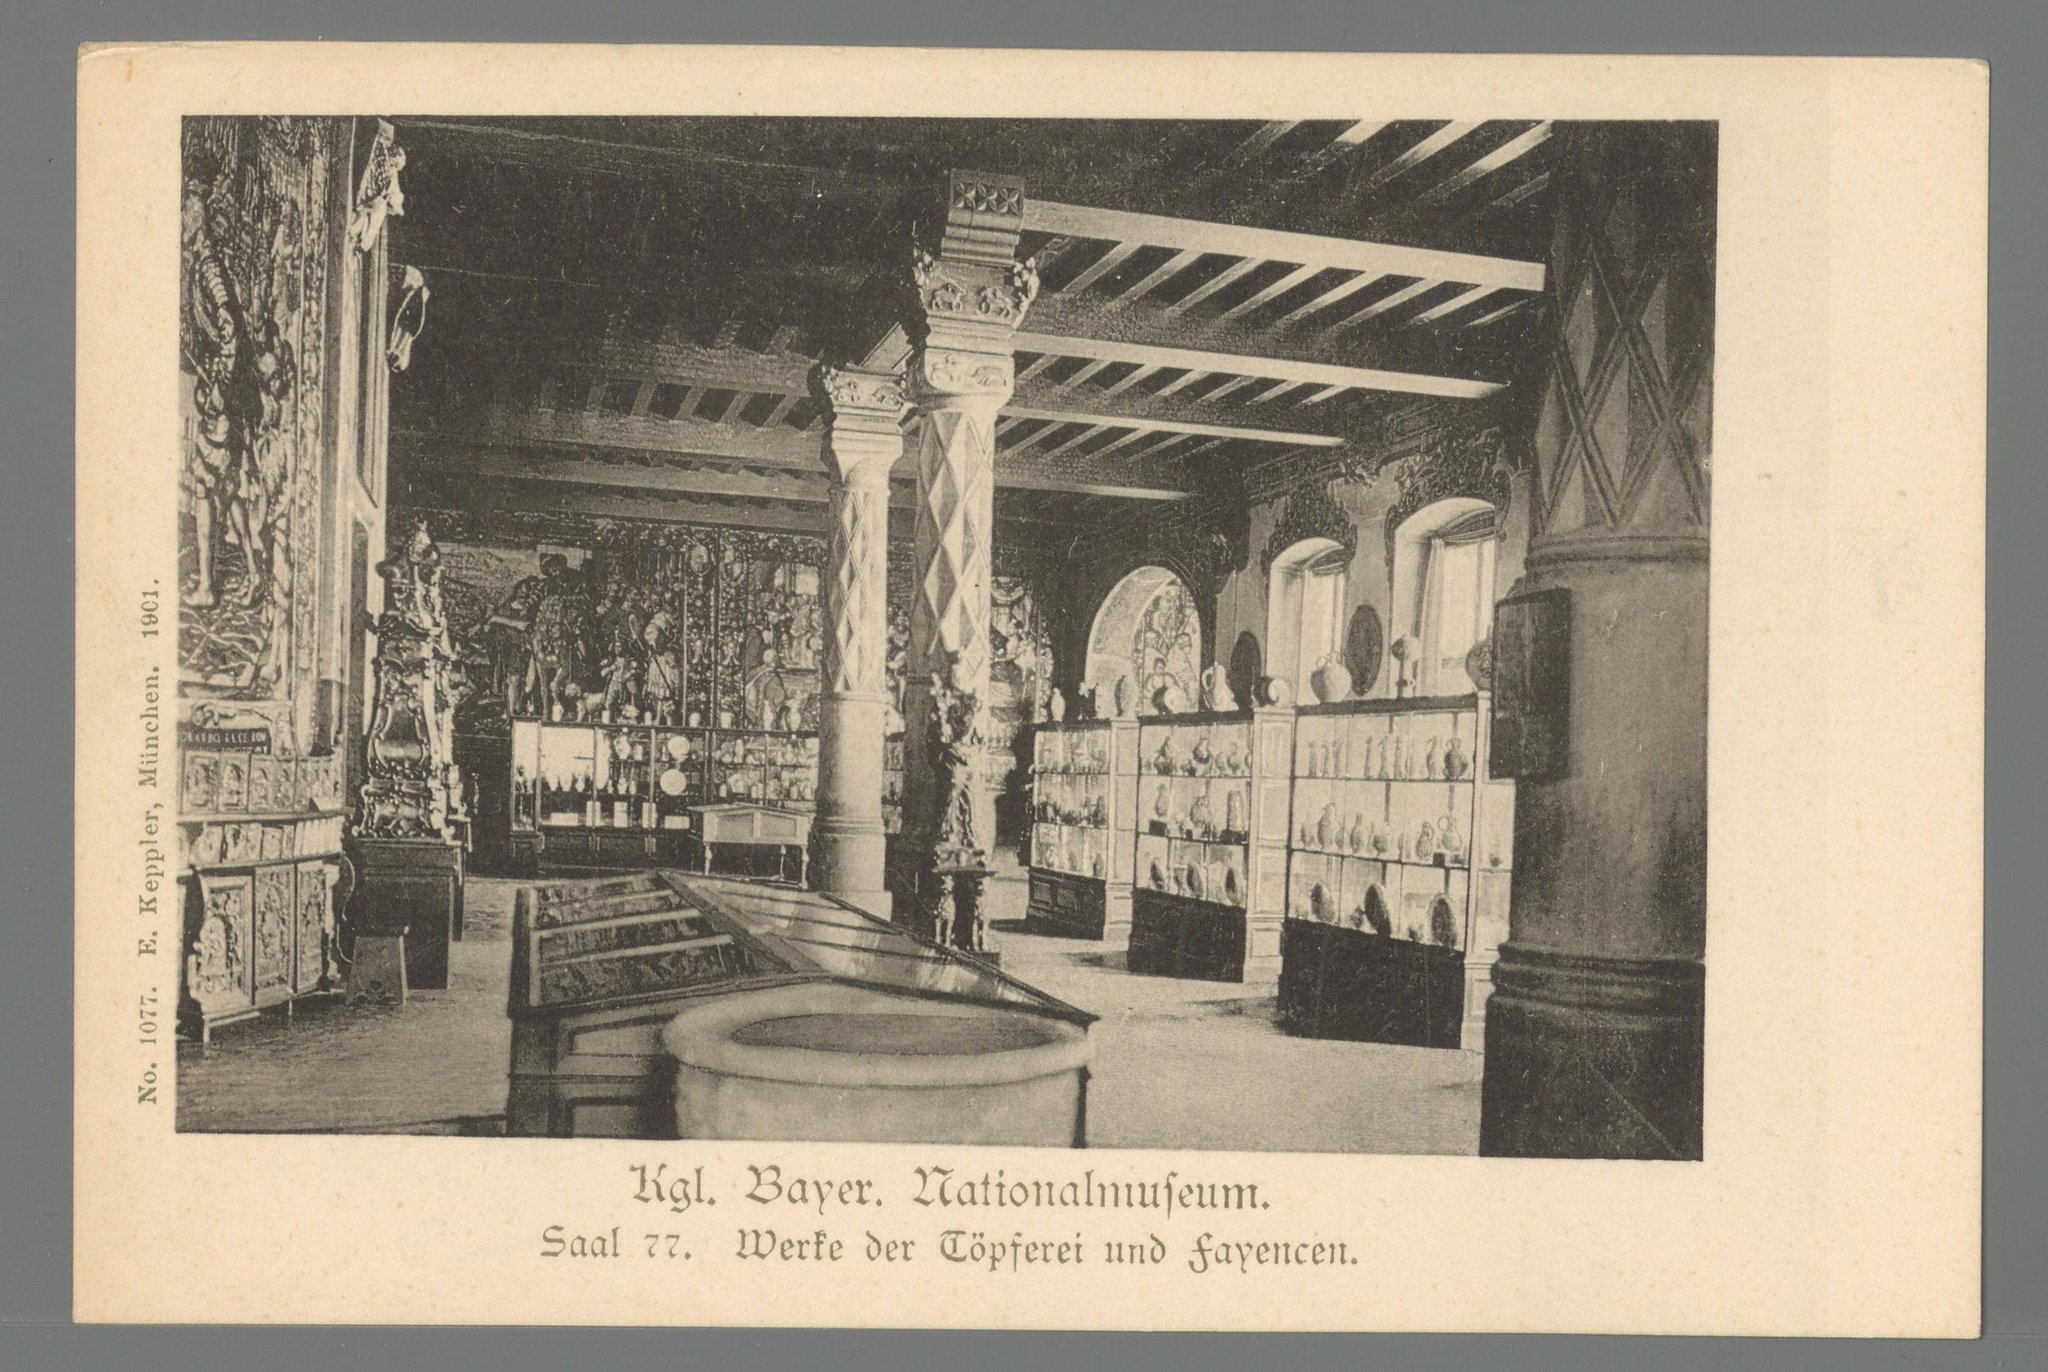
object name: photomechanical print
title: Kgl. Bayer. Nationalmuseum. Saal 77. Werke der Töpferei und Fayencen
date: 1901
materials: cardboard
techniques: photograph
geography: munich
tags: permanent exhibition, museum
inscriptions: date